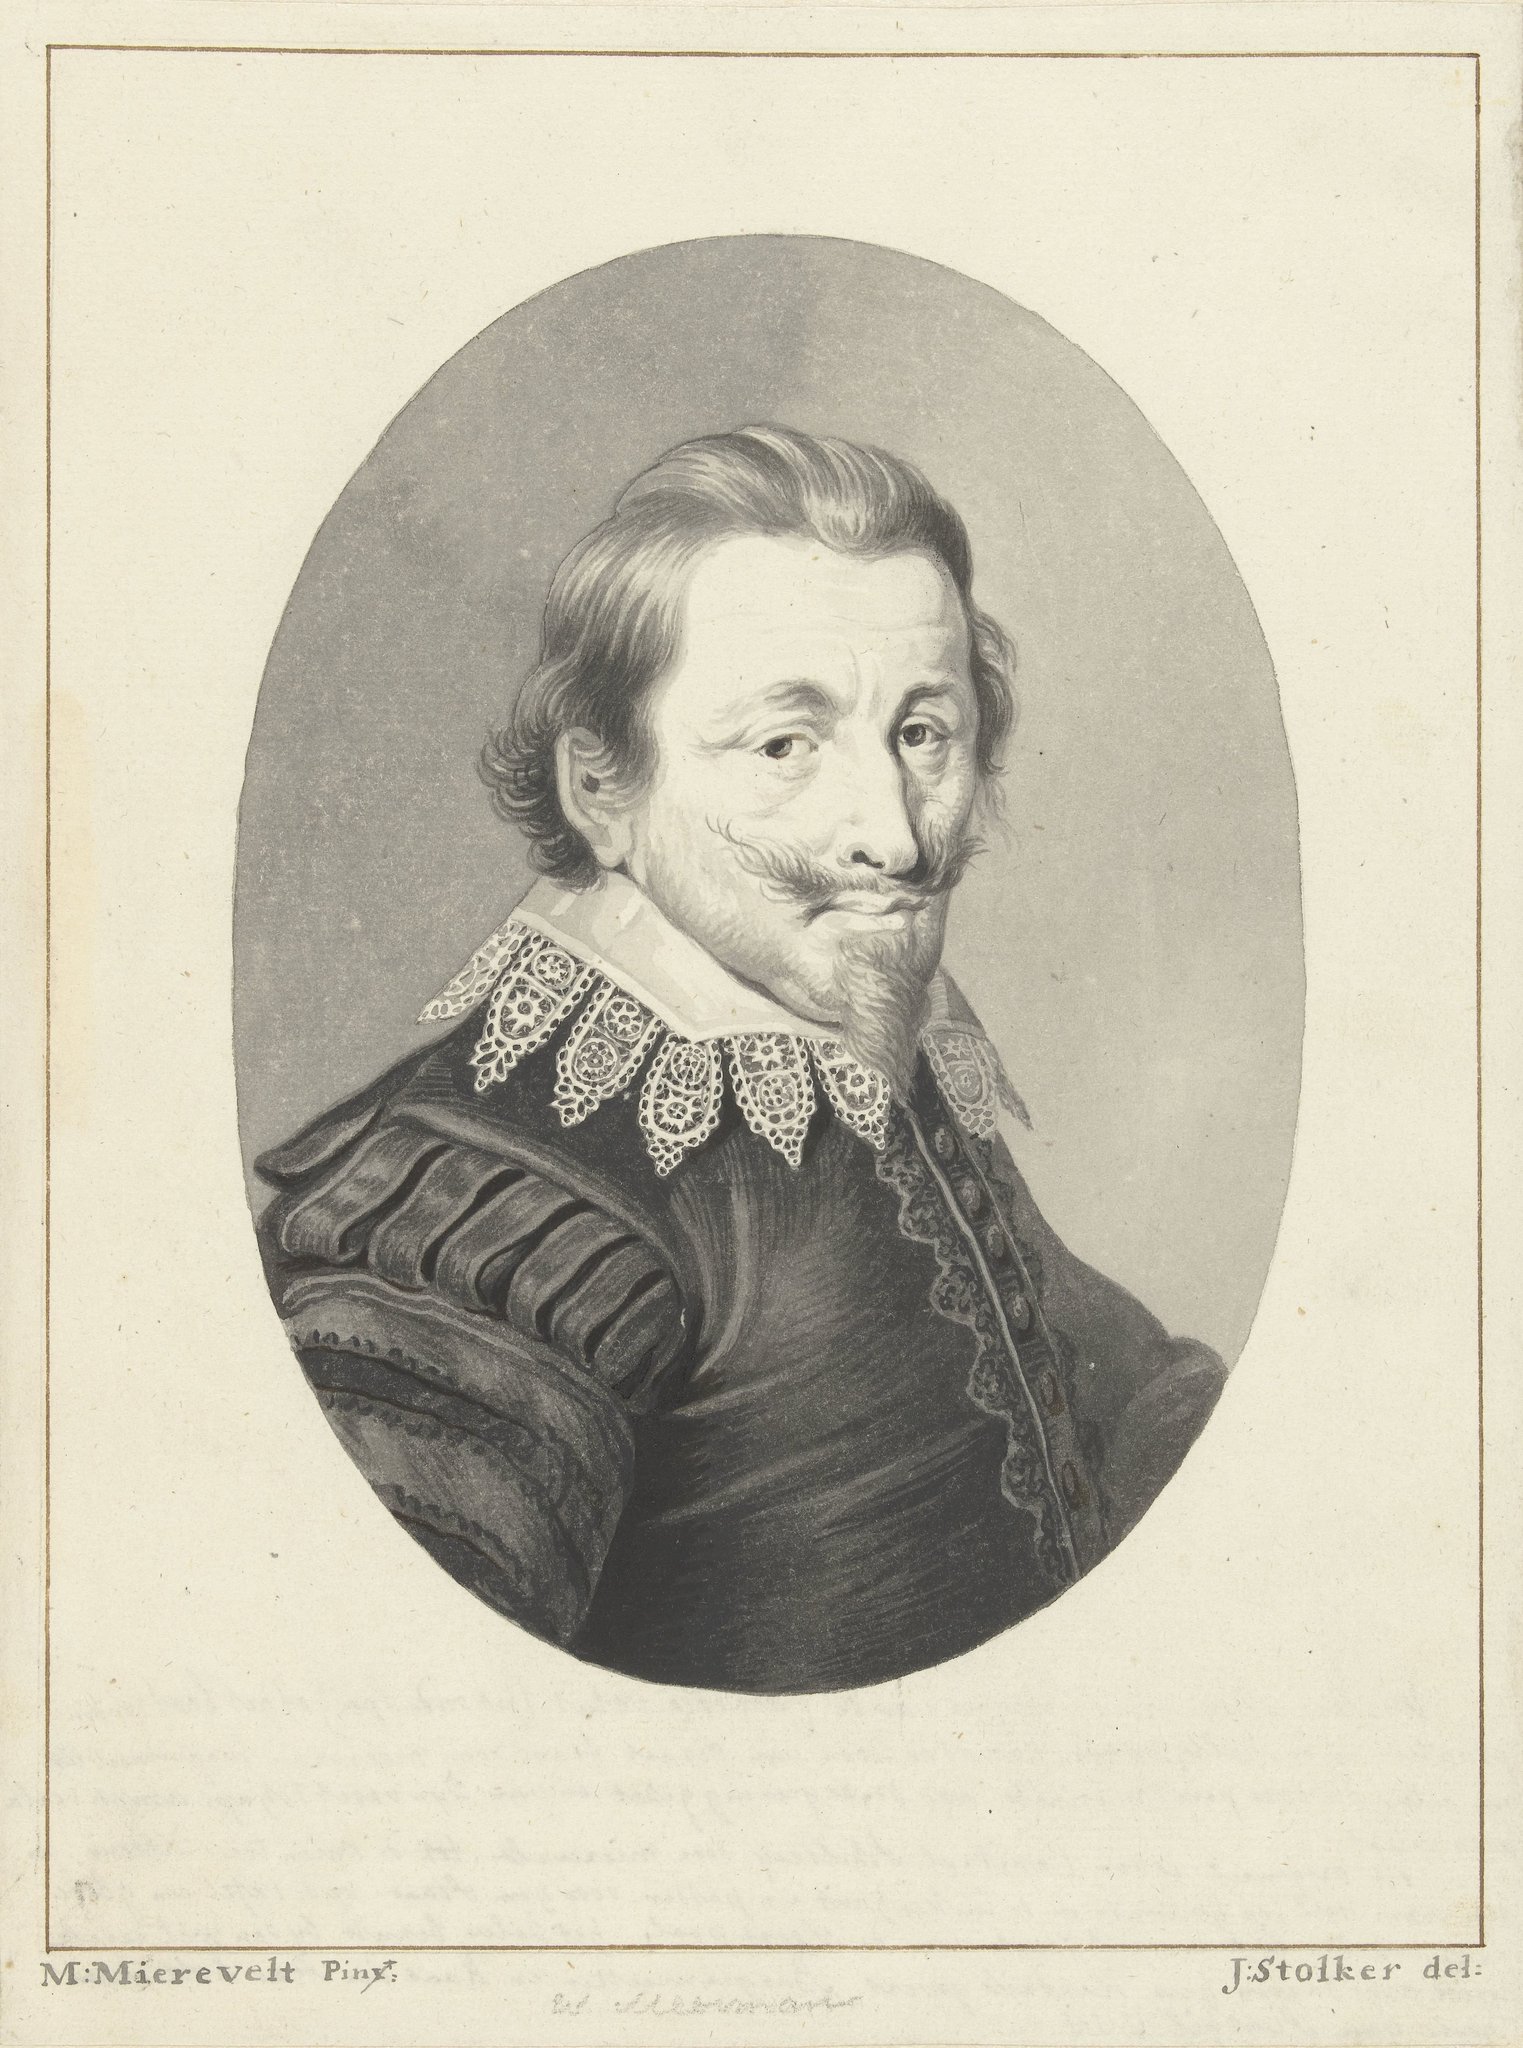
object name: drawing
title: Portret van de schrijver Willem Meerman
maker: jan stolker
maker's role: draughtsman, painter, print maker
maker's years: 1724-1785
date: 1734-1785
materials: ink, paper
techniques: brush, pen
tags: historical persons, portrait, self-portrait of artist, writer, poet, author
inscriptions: inscription: ‘Willem Meerman Schrijver van de Coemedia Vetus (het oude Spel)(...). dit origineel is een Capitaal Schildery door Mierevelt, tot de knieen toe (...).’, inscription: ‘M: Mierevelt Pinx: / J: Stolker del.’